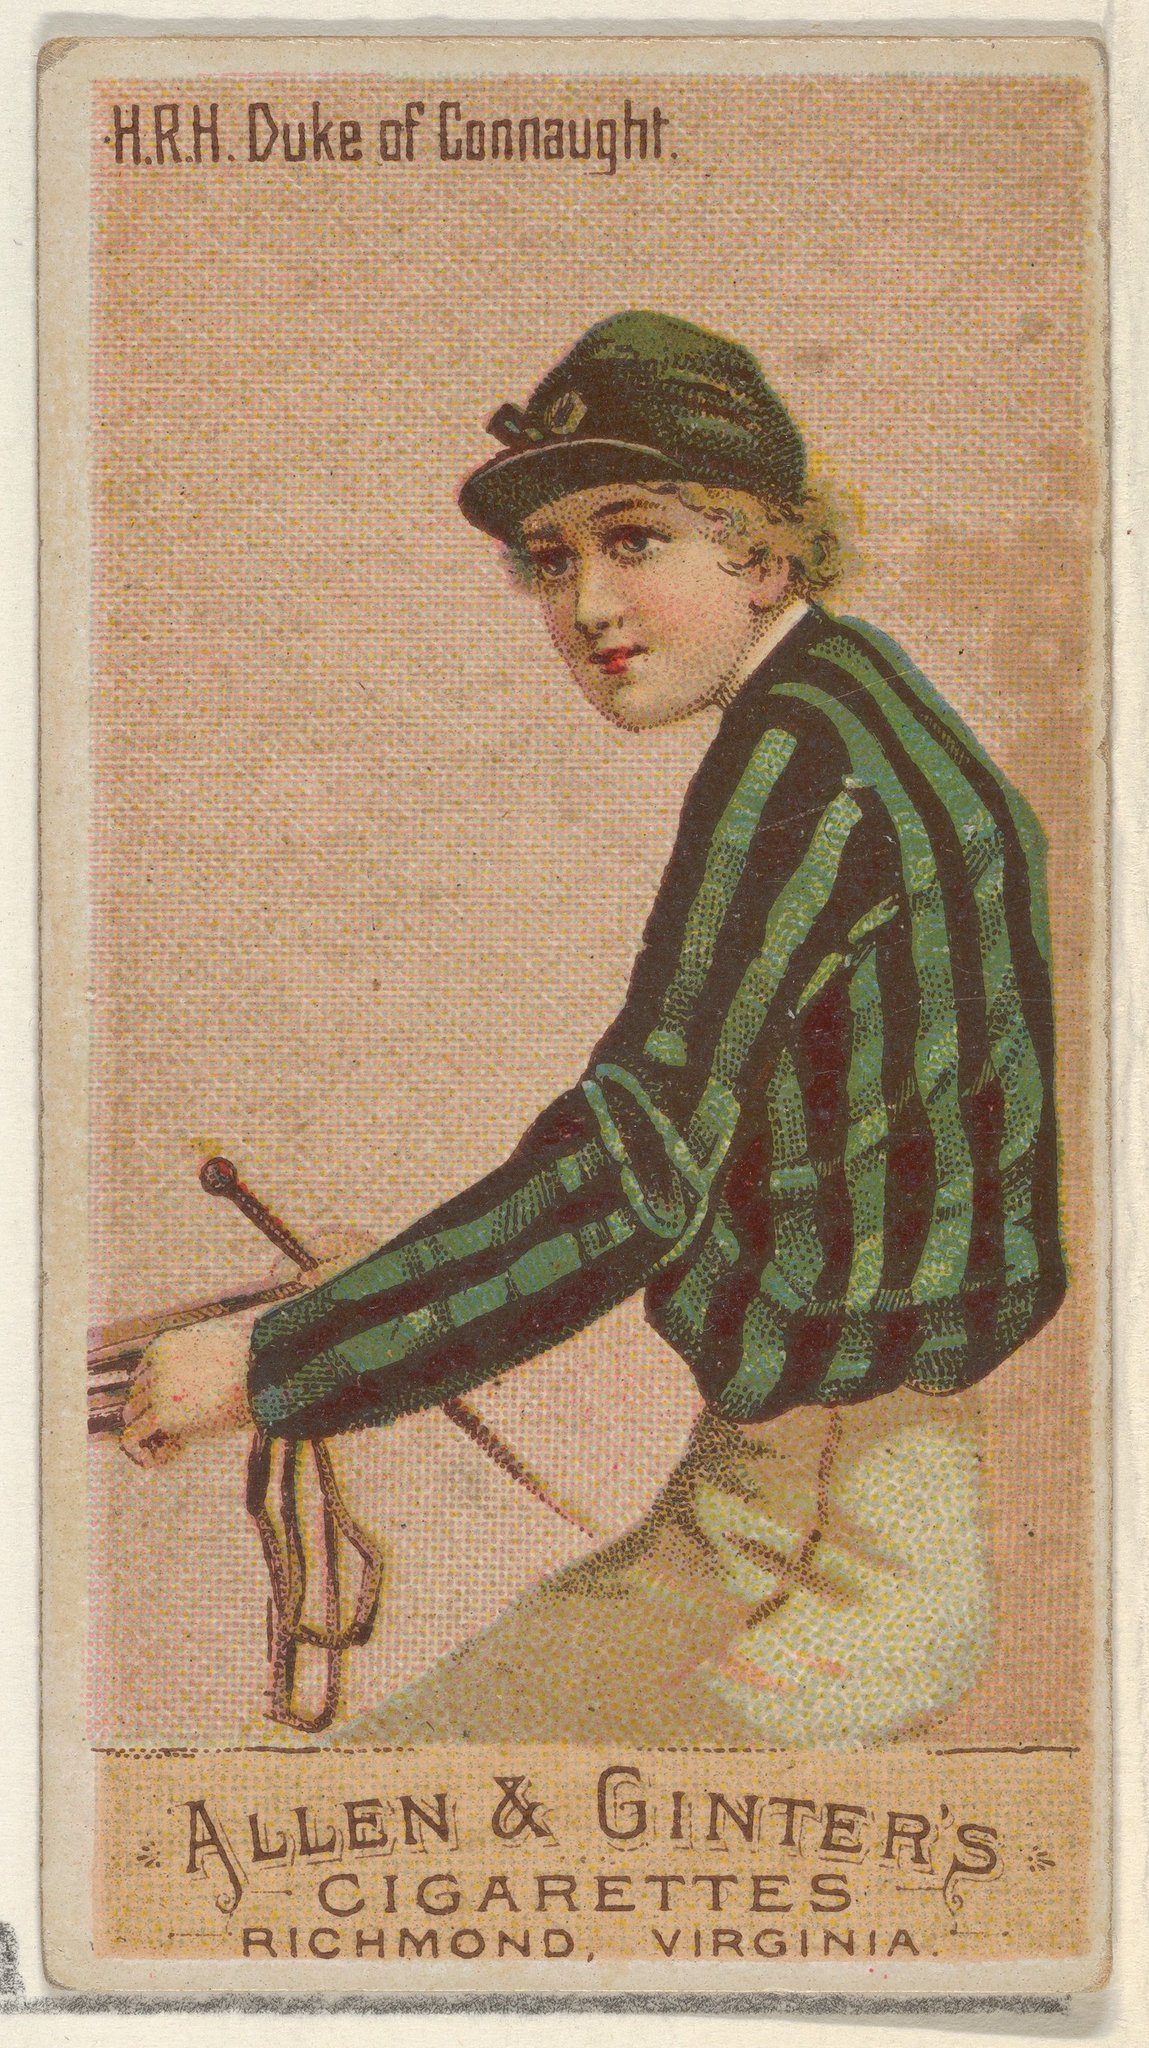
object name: print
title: H.R.H. Duke of Connaught, from the Racing Colors of the World series (N22a) for Allen & Ginter Cigarettes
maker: allen & ginter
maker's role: publisher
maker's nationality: american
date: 1888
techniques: color lithograph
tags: men,jockeys